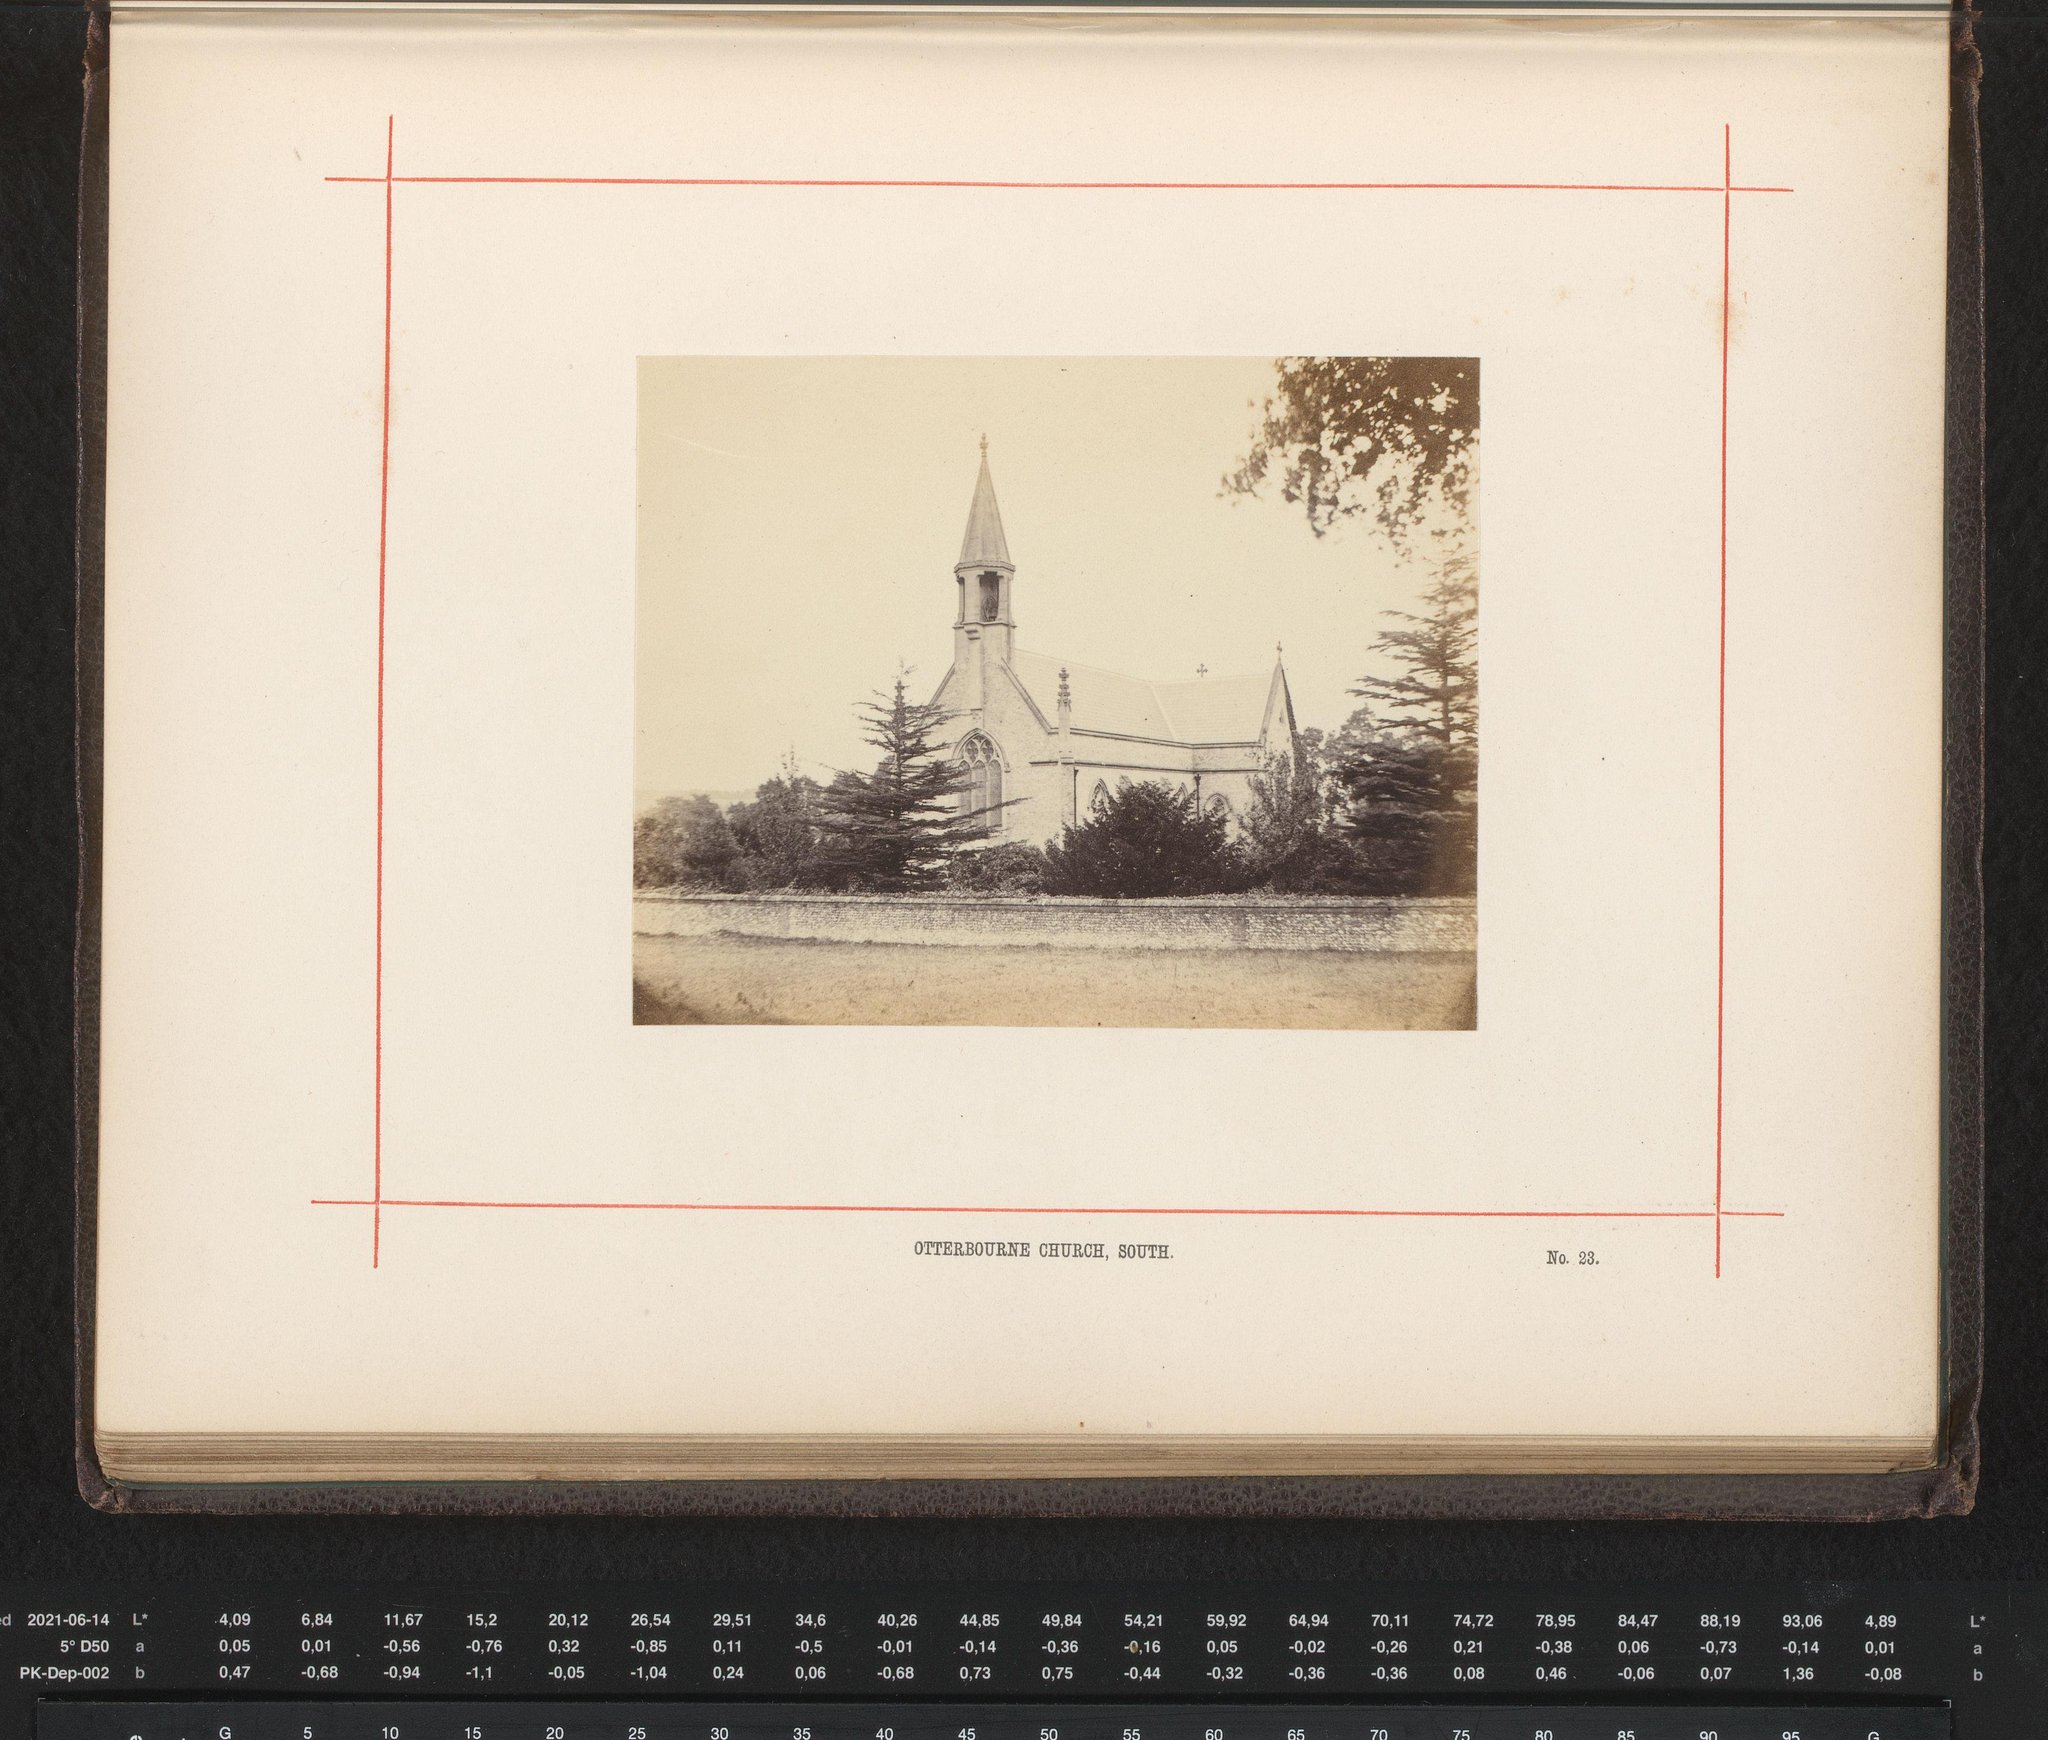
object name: photograph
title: Gezicht op Saint Matthew's Church in Otterbourne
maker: william savage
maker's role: fotograaf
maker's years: 1817-1887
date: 1861-1866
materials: paper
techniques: albumen print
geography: otterbourne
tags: church (exterior)